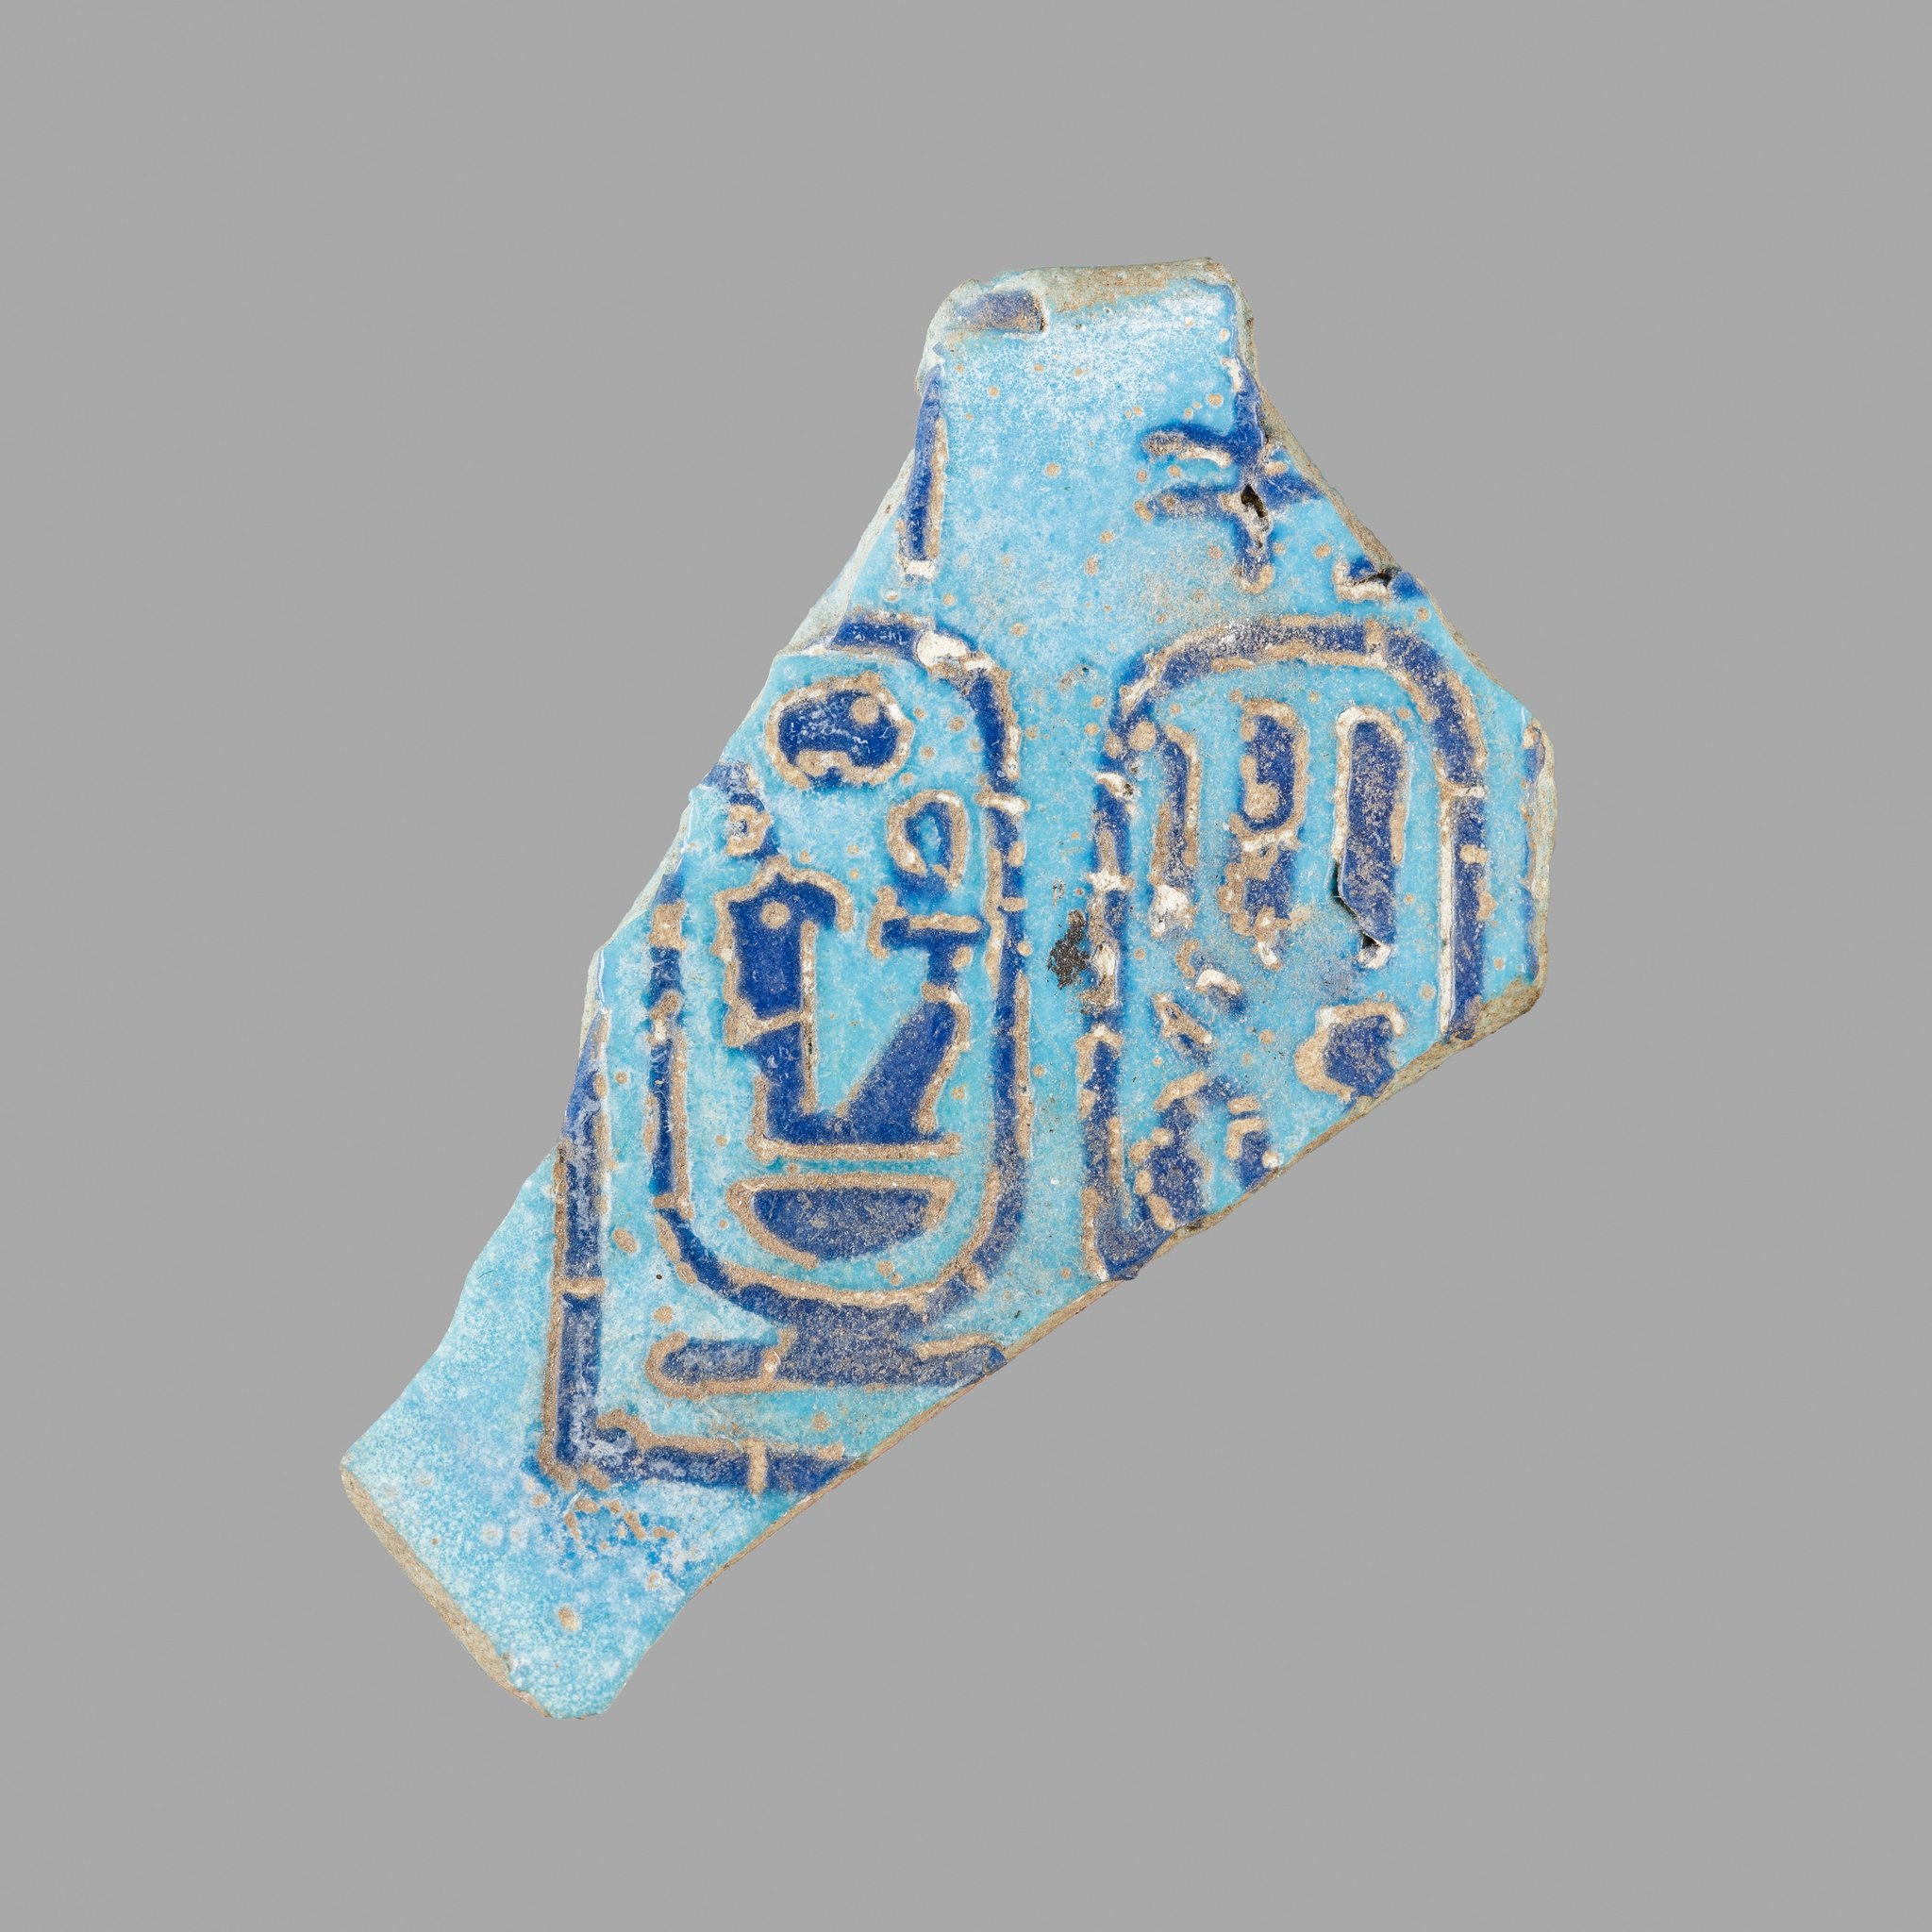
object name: fragment of a dish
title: Fragment of a Toilet Dish with Cartouches of Amenhotep III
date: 1390-1352 BCE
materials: faience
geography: egypt